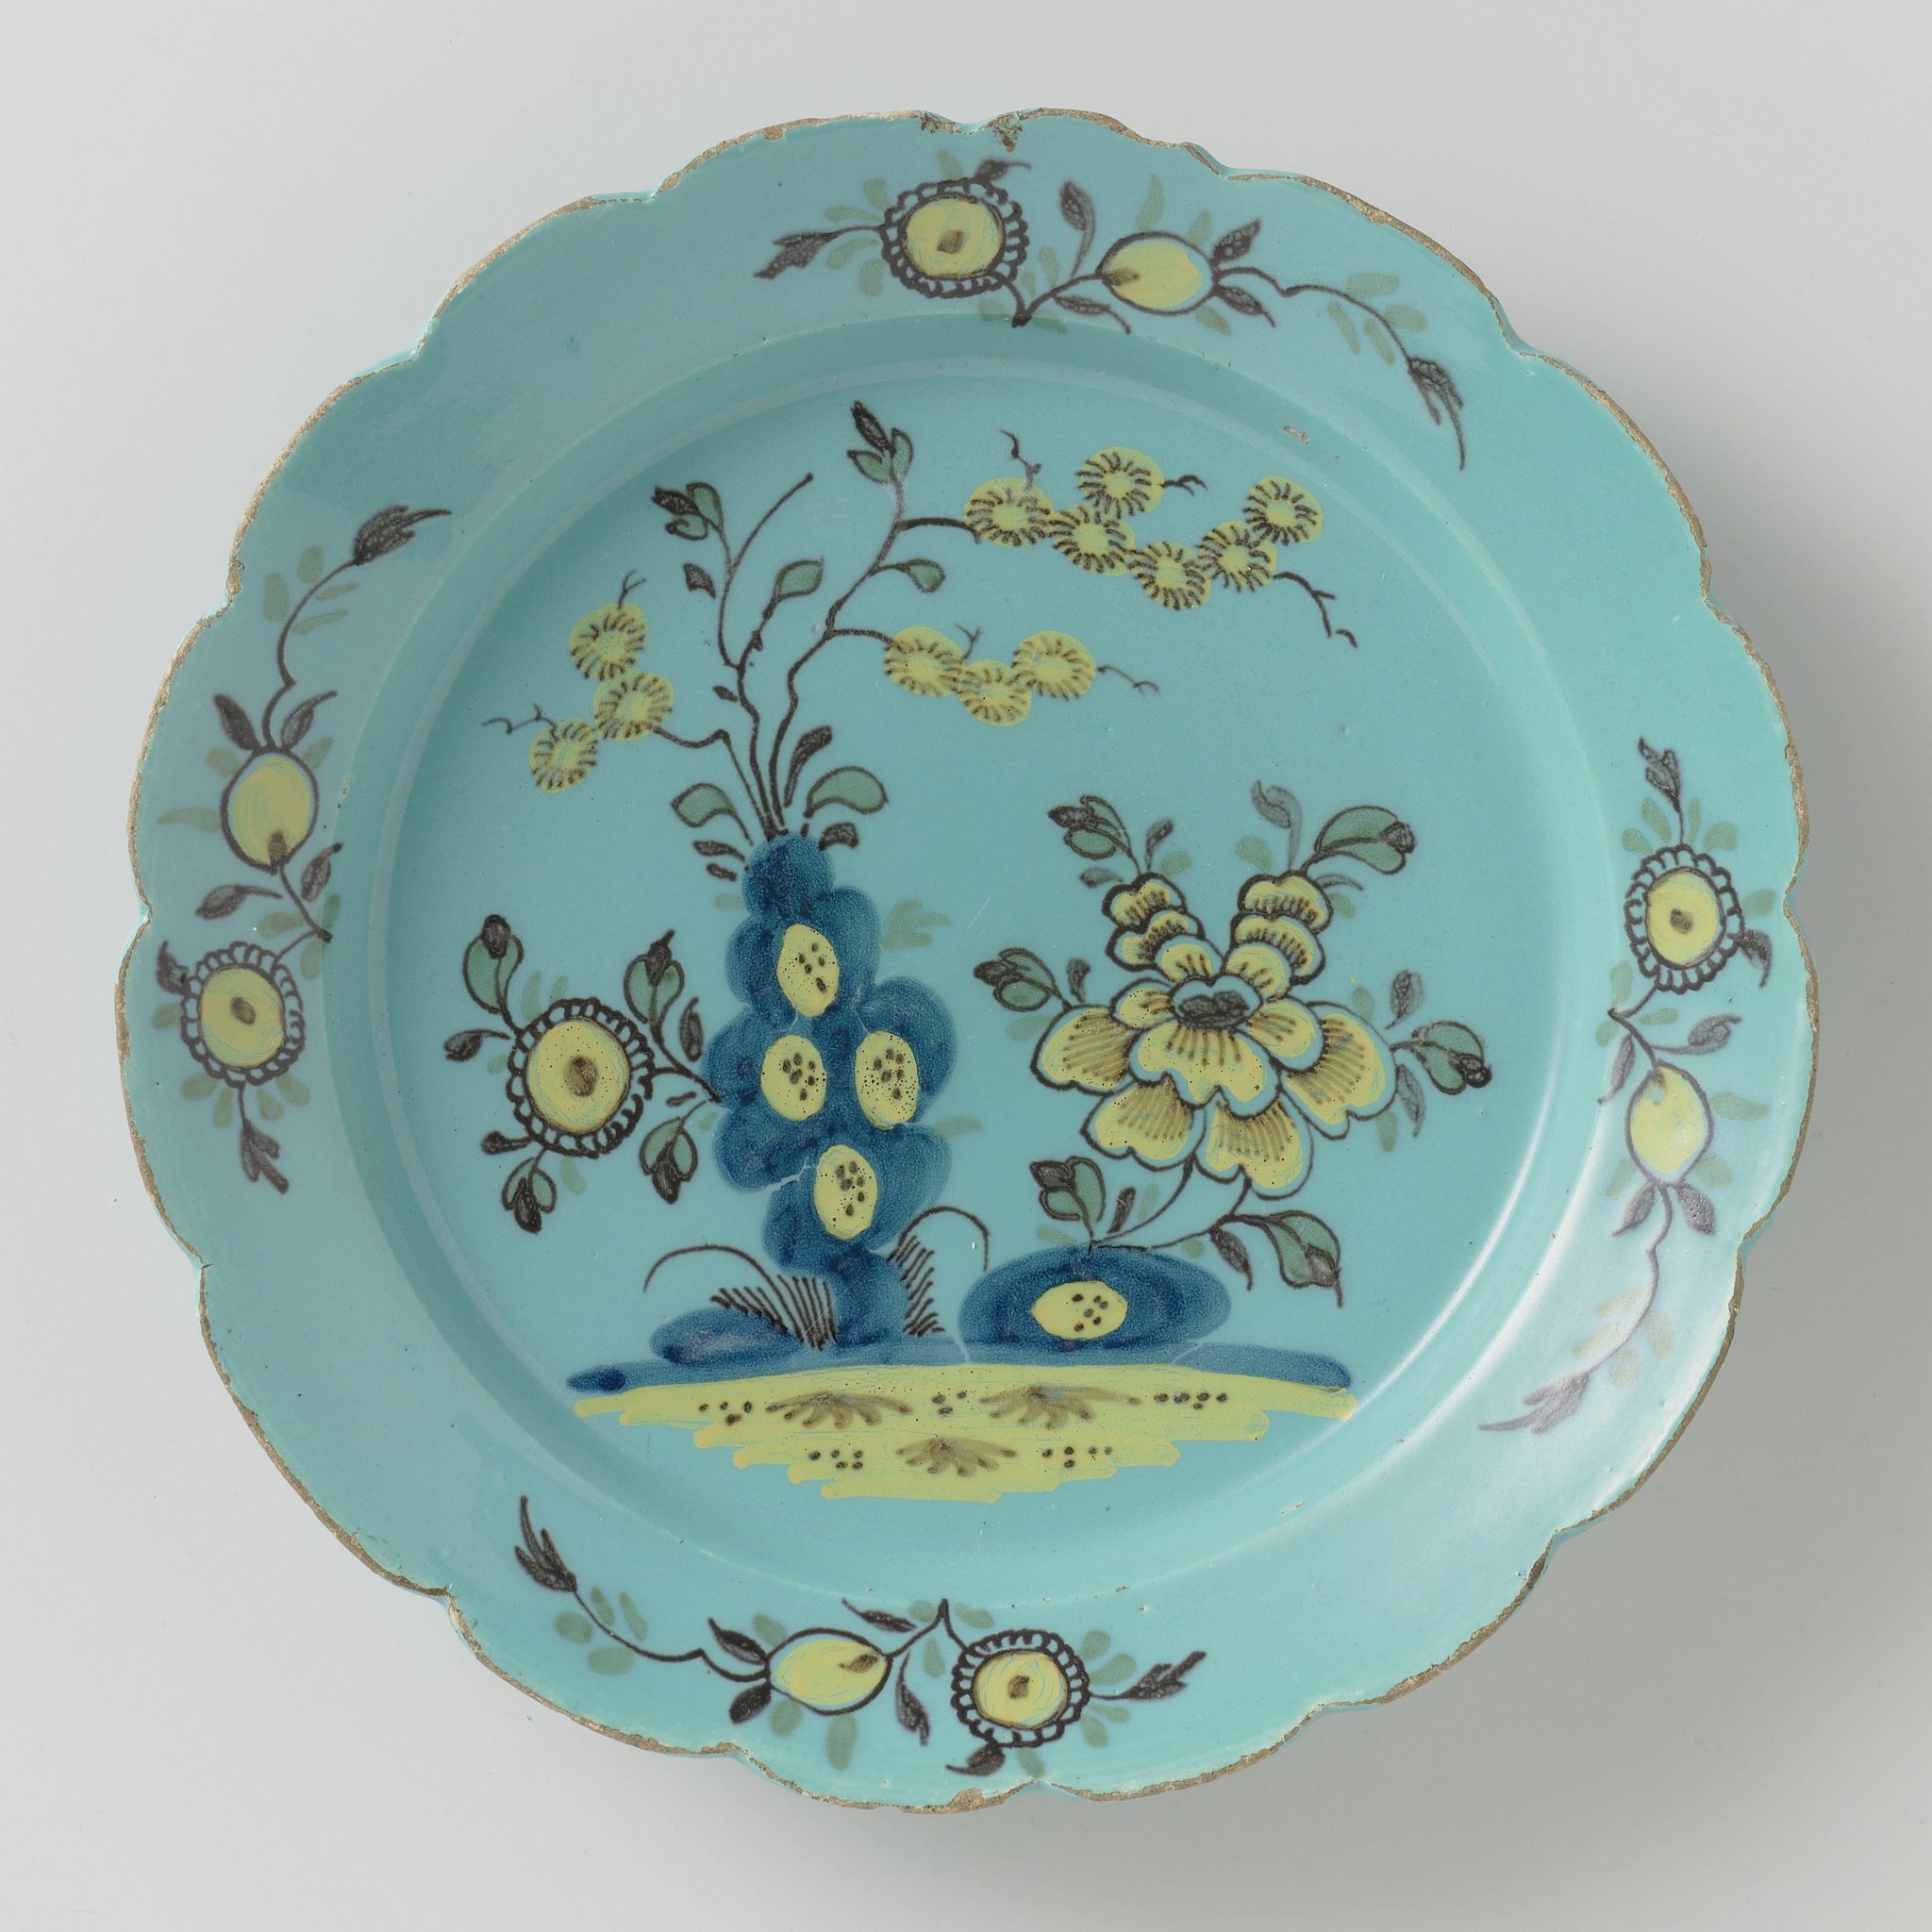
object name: plate dish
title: Bord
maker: Anonymous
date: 1725-1760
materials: earthenware, glaze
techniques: painted, polychromy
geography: delft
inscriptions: collector's mark, o: ‘koninklijk oudheidkundig genootschap no. 13’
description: Rond bord van veelkleurig beschilderde faience, met een turkoois fonde en een geschulpte rand. Op het plat zijn bloemen op een grond in de kleuren blauw, geel en mangaan geschilderd. Op de rand zijn vier bloemmotieven geschilderd in de kleuren groen, geel en mangaan.